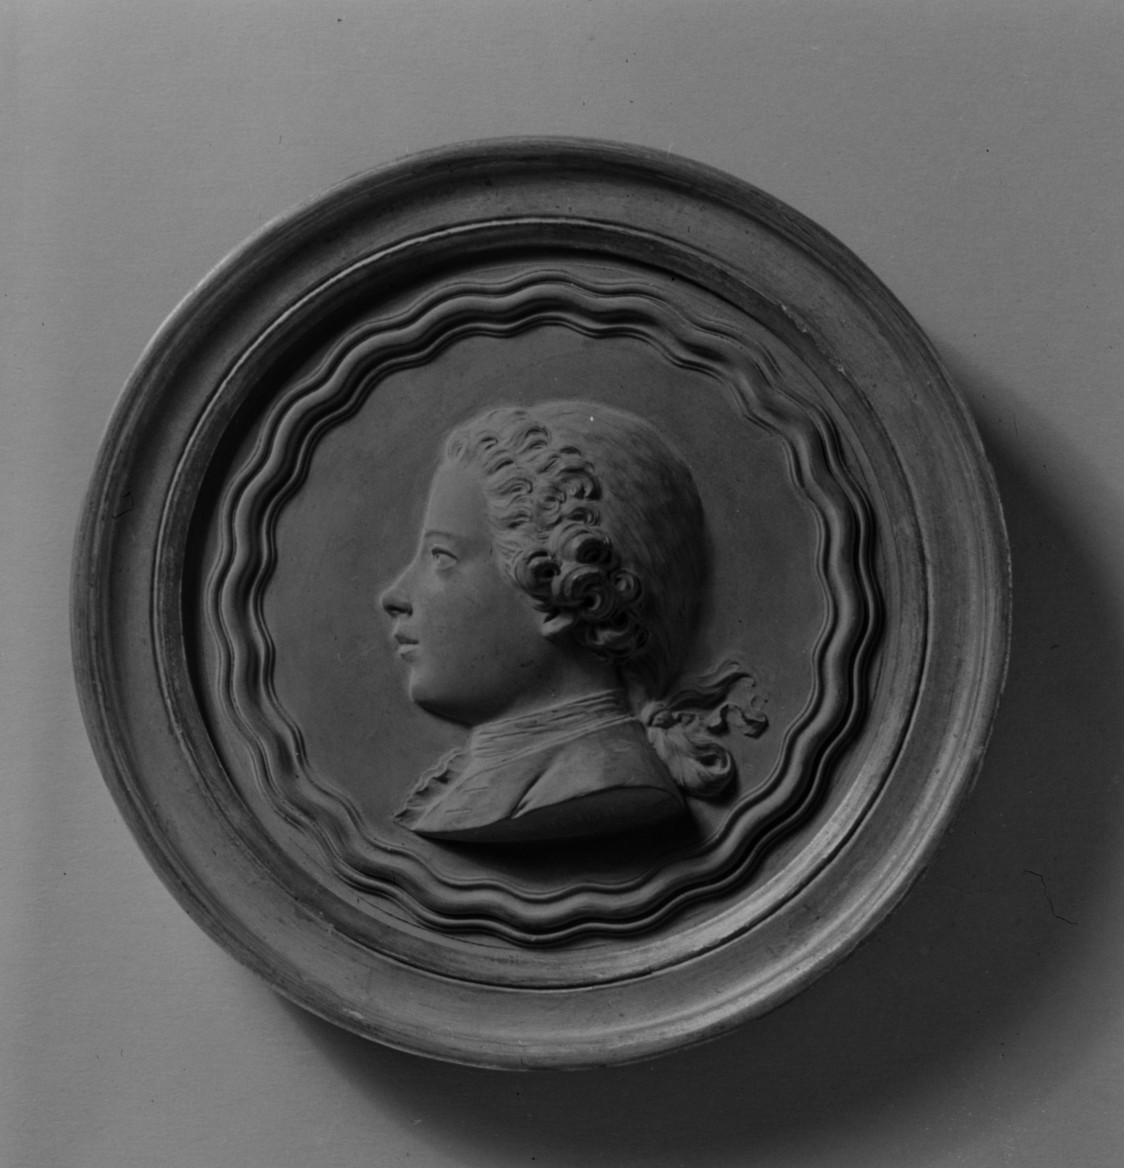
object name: medallion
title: Louis-Nicolas Bernot de Mouchy, 1764, at the Age of 16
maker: jean-baptiste nini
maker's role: artist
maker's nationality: italian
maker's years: 1717-1786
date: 1764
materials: gilt, terracotta, wood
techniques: casting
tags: men,profiles